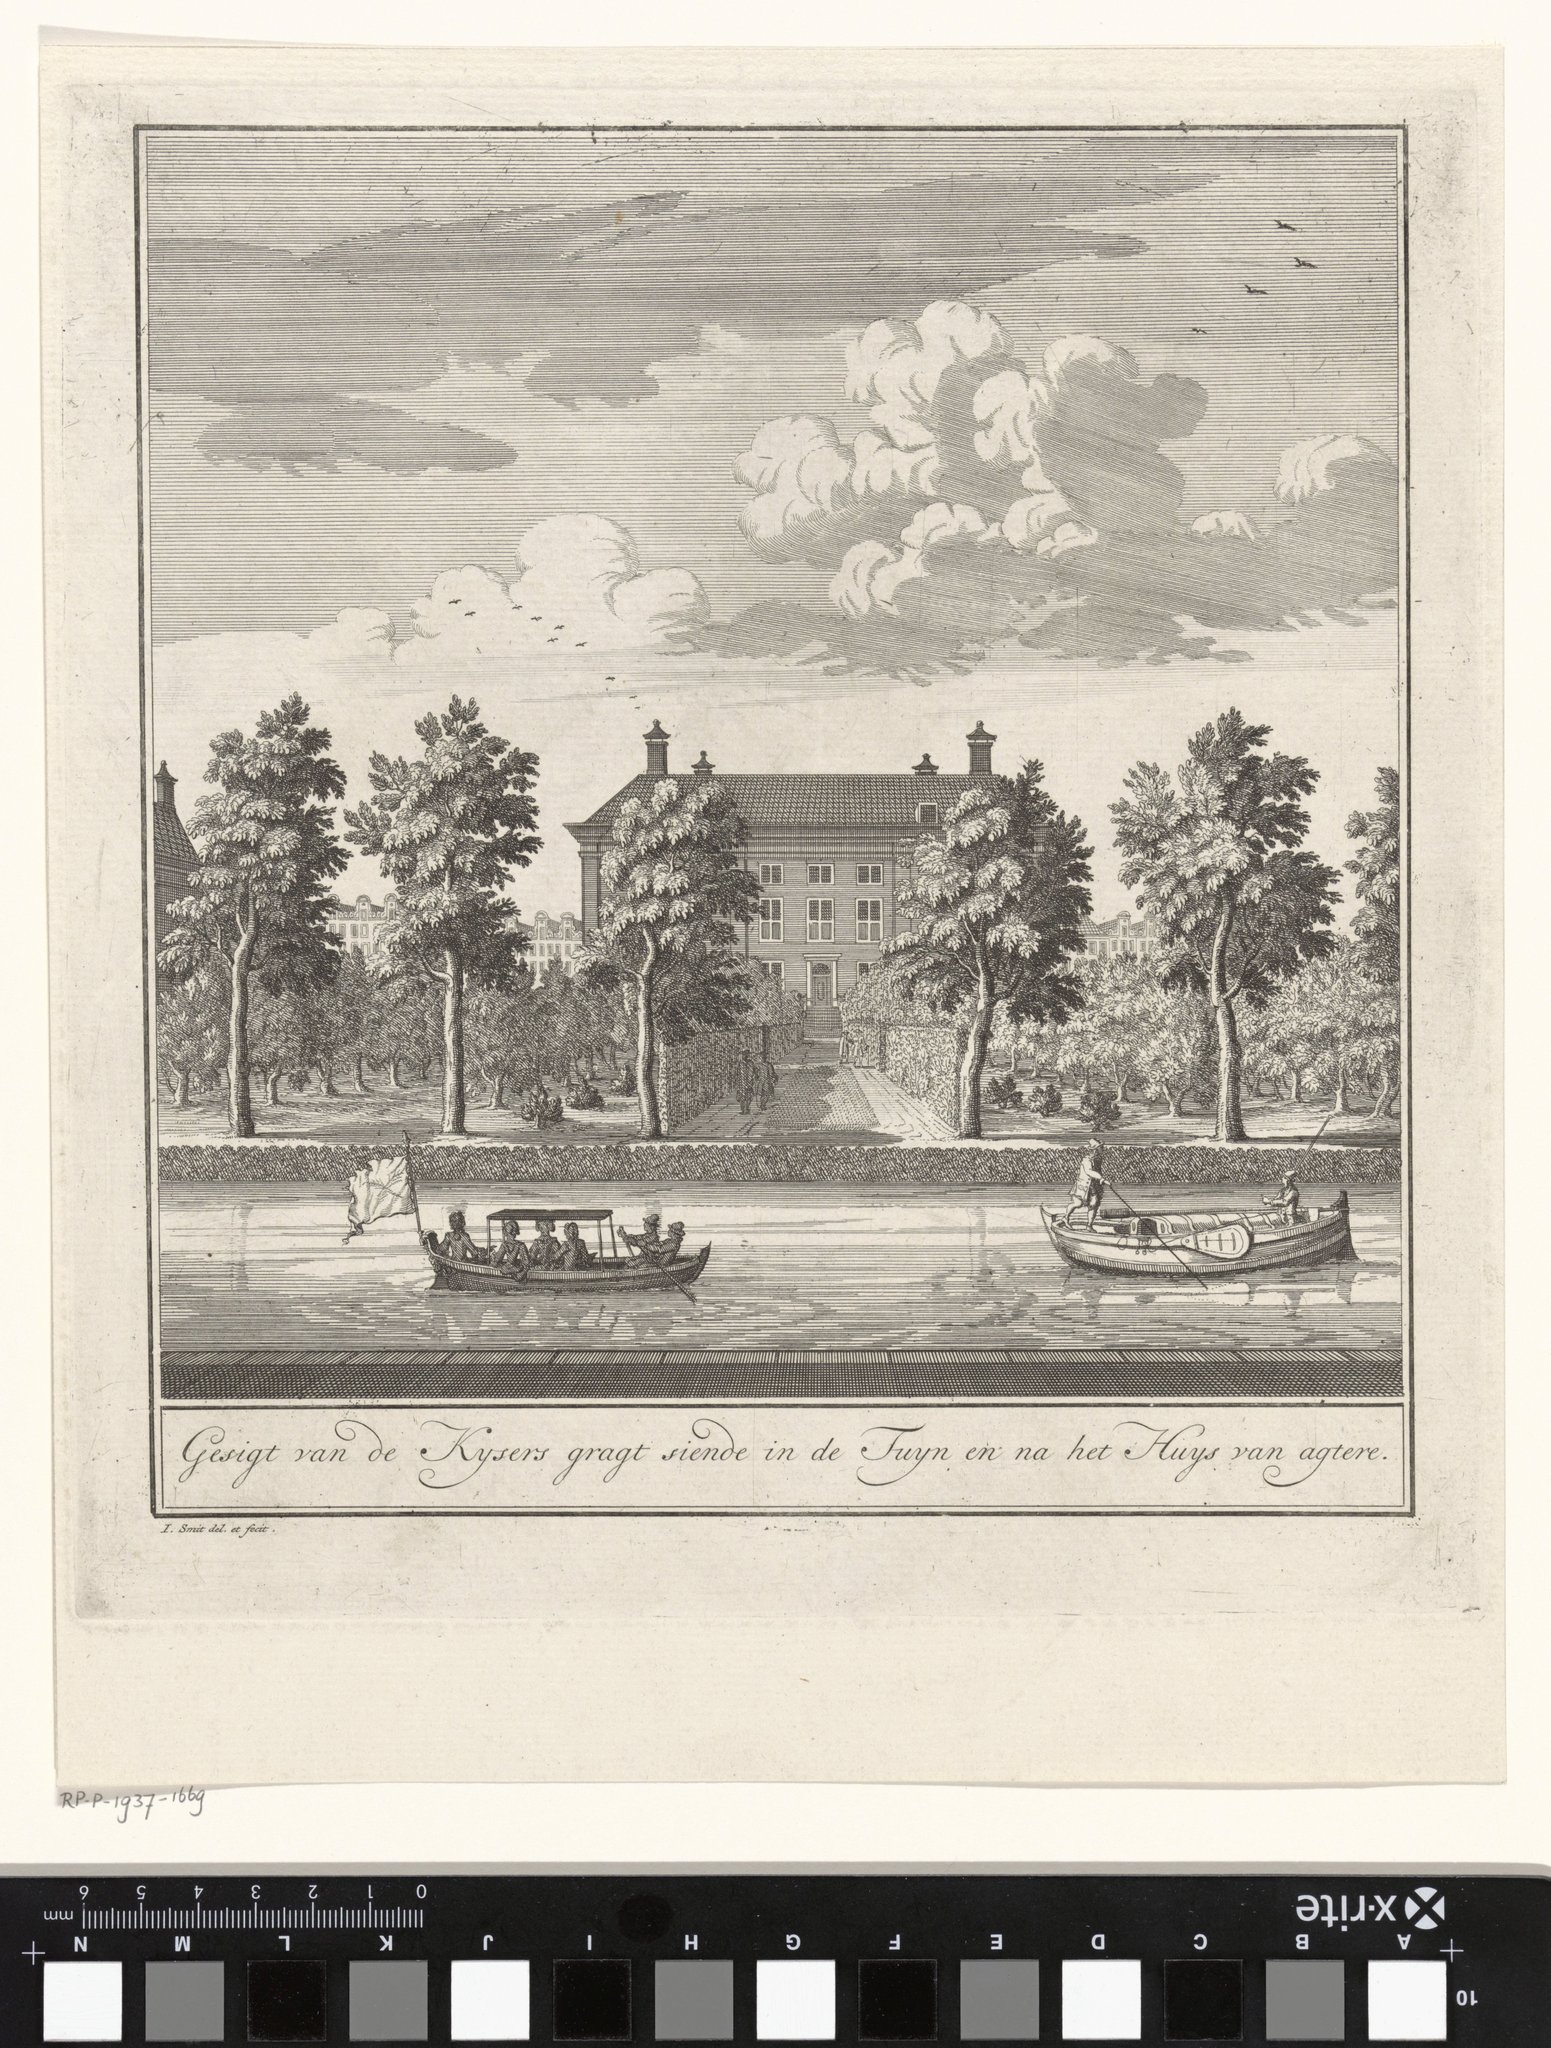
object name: print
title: Het Corvershof te Amsterdam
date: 1723-1748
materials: paper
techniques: engraving, etching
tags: alms-house (dutch: 'hofje'), public welfare, french or architectonic garden; formal garden, rowing-boat, canoe, etc., orchard, canals, waters (in city) (+ city(-scape) with figures, staffage), old-people's home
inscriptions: collector's mark: Lugt 2228, collector's mark: Lugt 2760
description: Gezicht op de tuin en de achtergevel het Corvershof aan de Nieuwe Herengracht te Amsterdam, gezien vanaf de Nieuwe Keizersgracht. Aan weerszijden van het middenpad een boomgaard. In de gracht twee boten. Onderdeel van een serie prenten van het in 1723 in gebruik genomen Corvershof, bestemd voor oudere echtparen van Nederduits Gereformeerde (later Hervormde) huize.